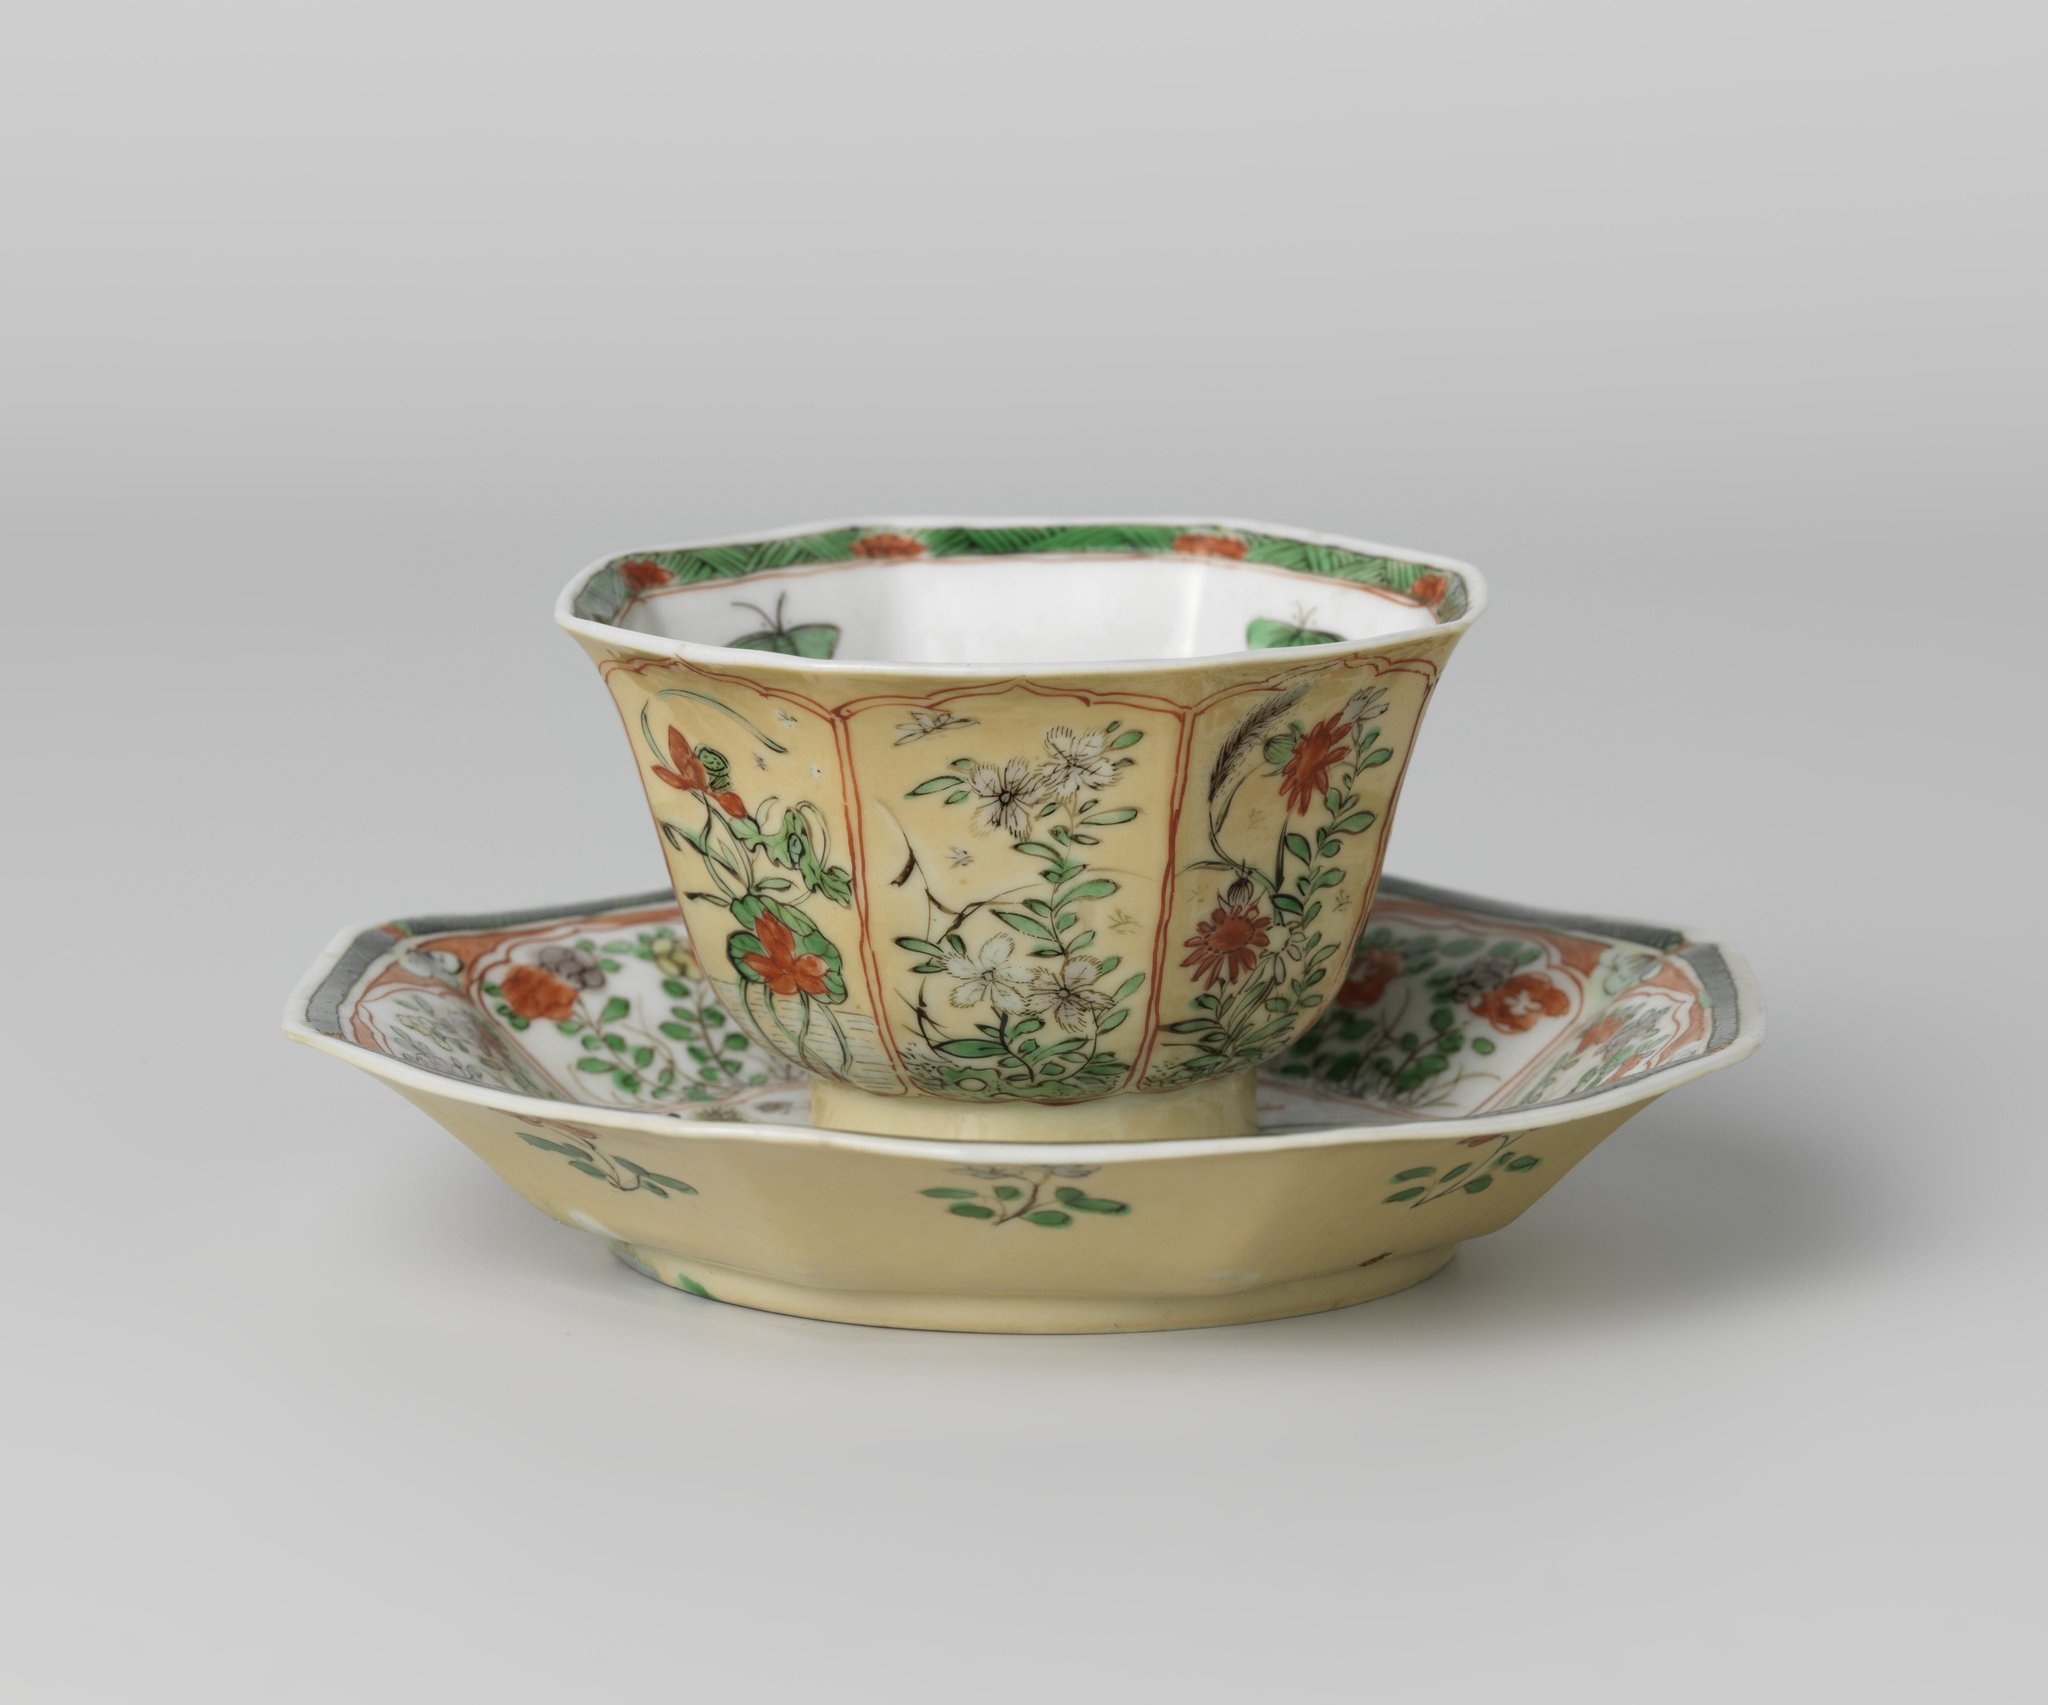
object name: kop en schotel, kop en schotel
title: Octagonal cup and saucer with light brown, animals and flower sprays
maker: Anonymous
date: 1700-1724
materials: cobalt, glaze, paint, porcelain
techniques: firing, forming, turning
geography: china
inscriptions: mark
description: Kop en schotel, achtkantig, cafe-au-lait, famille verte, met decors van bloeiende planten, haasjes en vogels. Op de buitenzijde zijn op een zeemleerkleurig fond bloempjes in afstekende kleuren aangebracht.